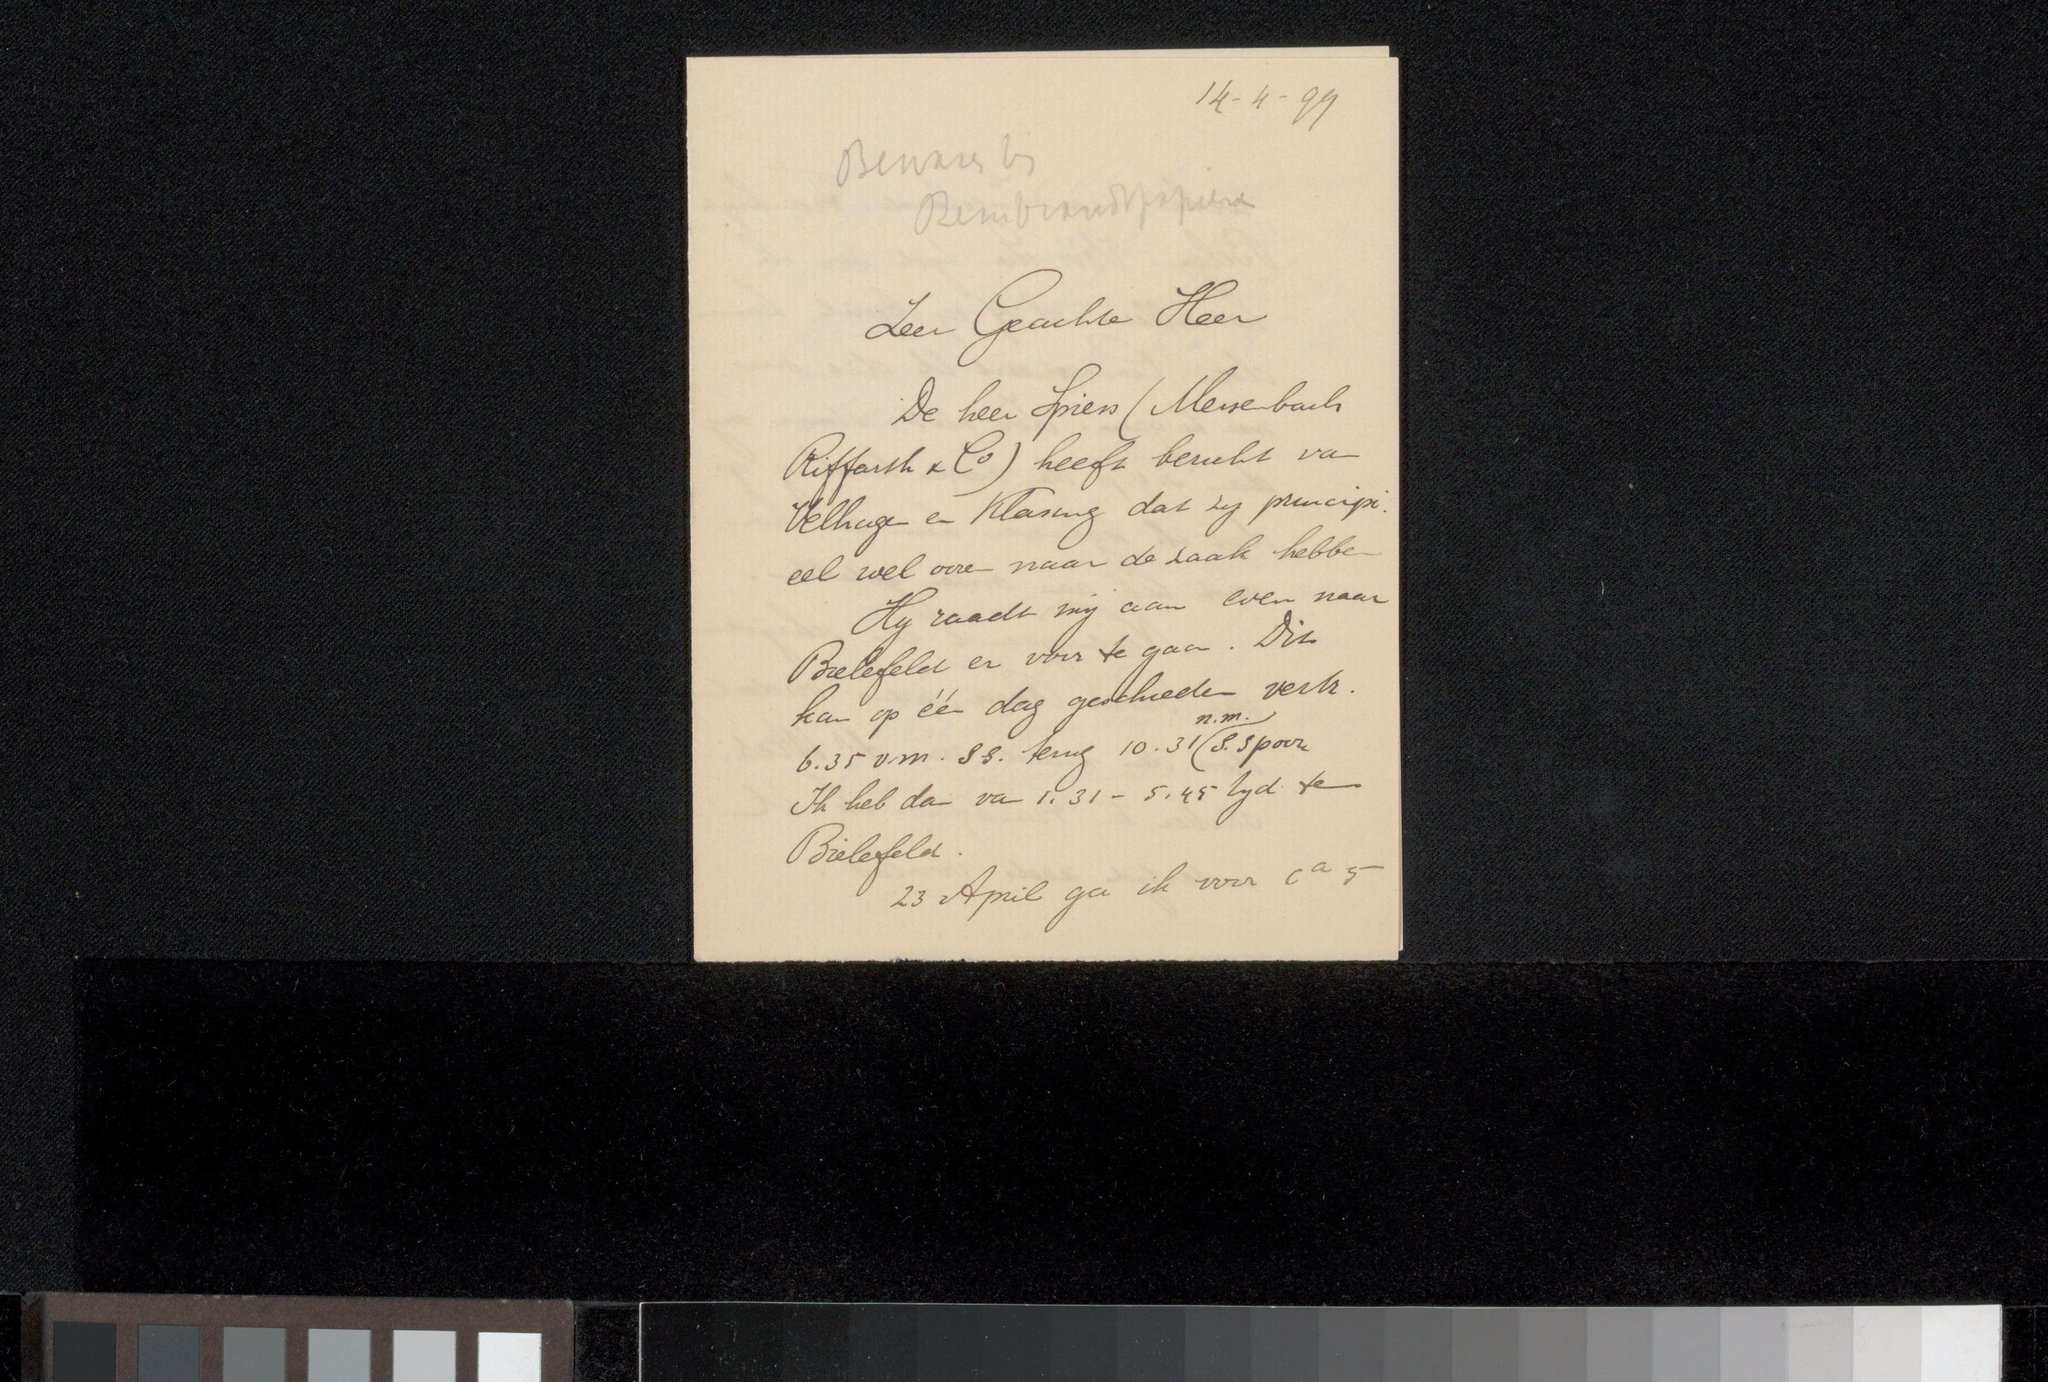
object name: letter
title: Brief aan Jan Veth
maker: cornelis hofstede de groot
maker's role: kunsthistoricus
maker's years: 1863-1940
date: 1899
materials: ink, paper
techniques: pen, writing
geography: amsterdam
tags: politician, martin rade, printer, publisher, painter, print maker, draughtsman, jan veth, money, printed matter, france, england, belgium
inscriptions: collector's mark: ‘RPK’